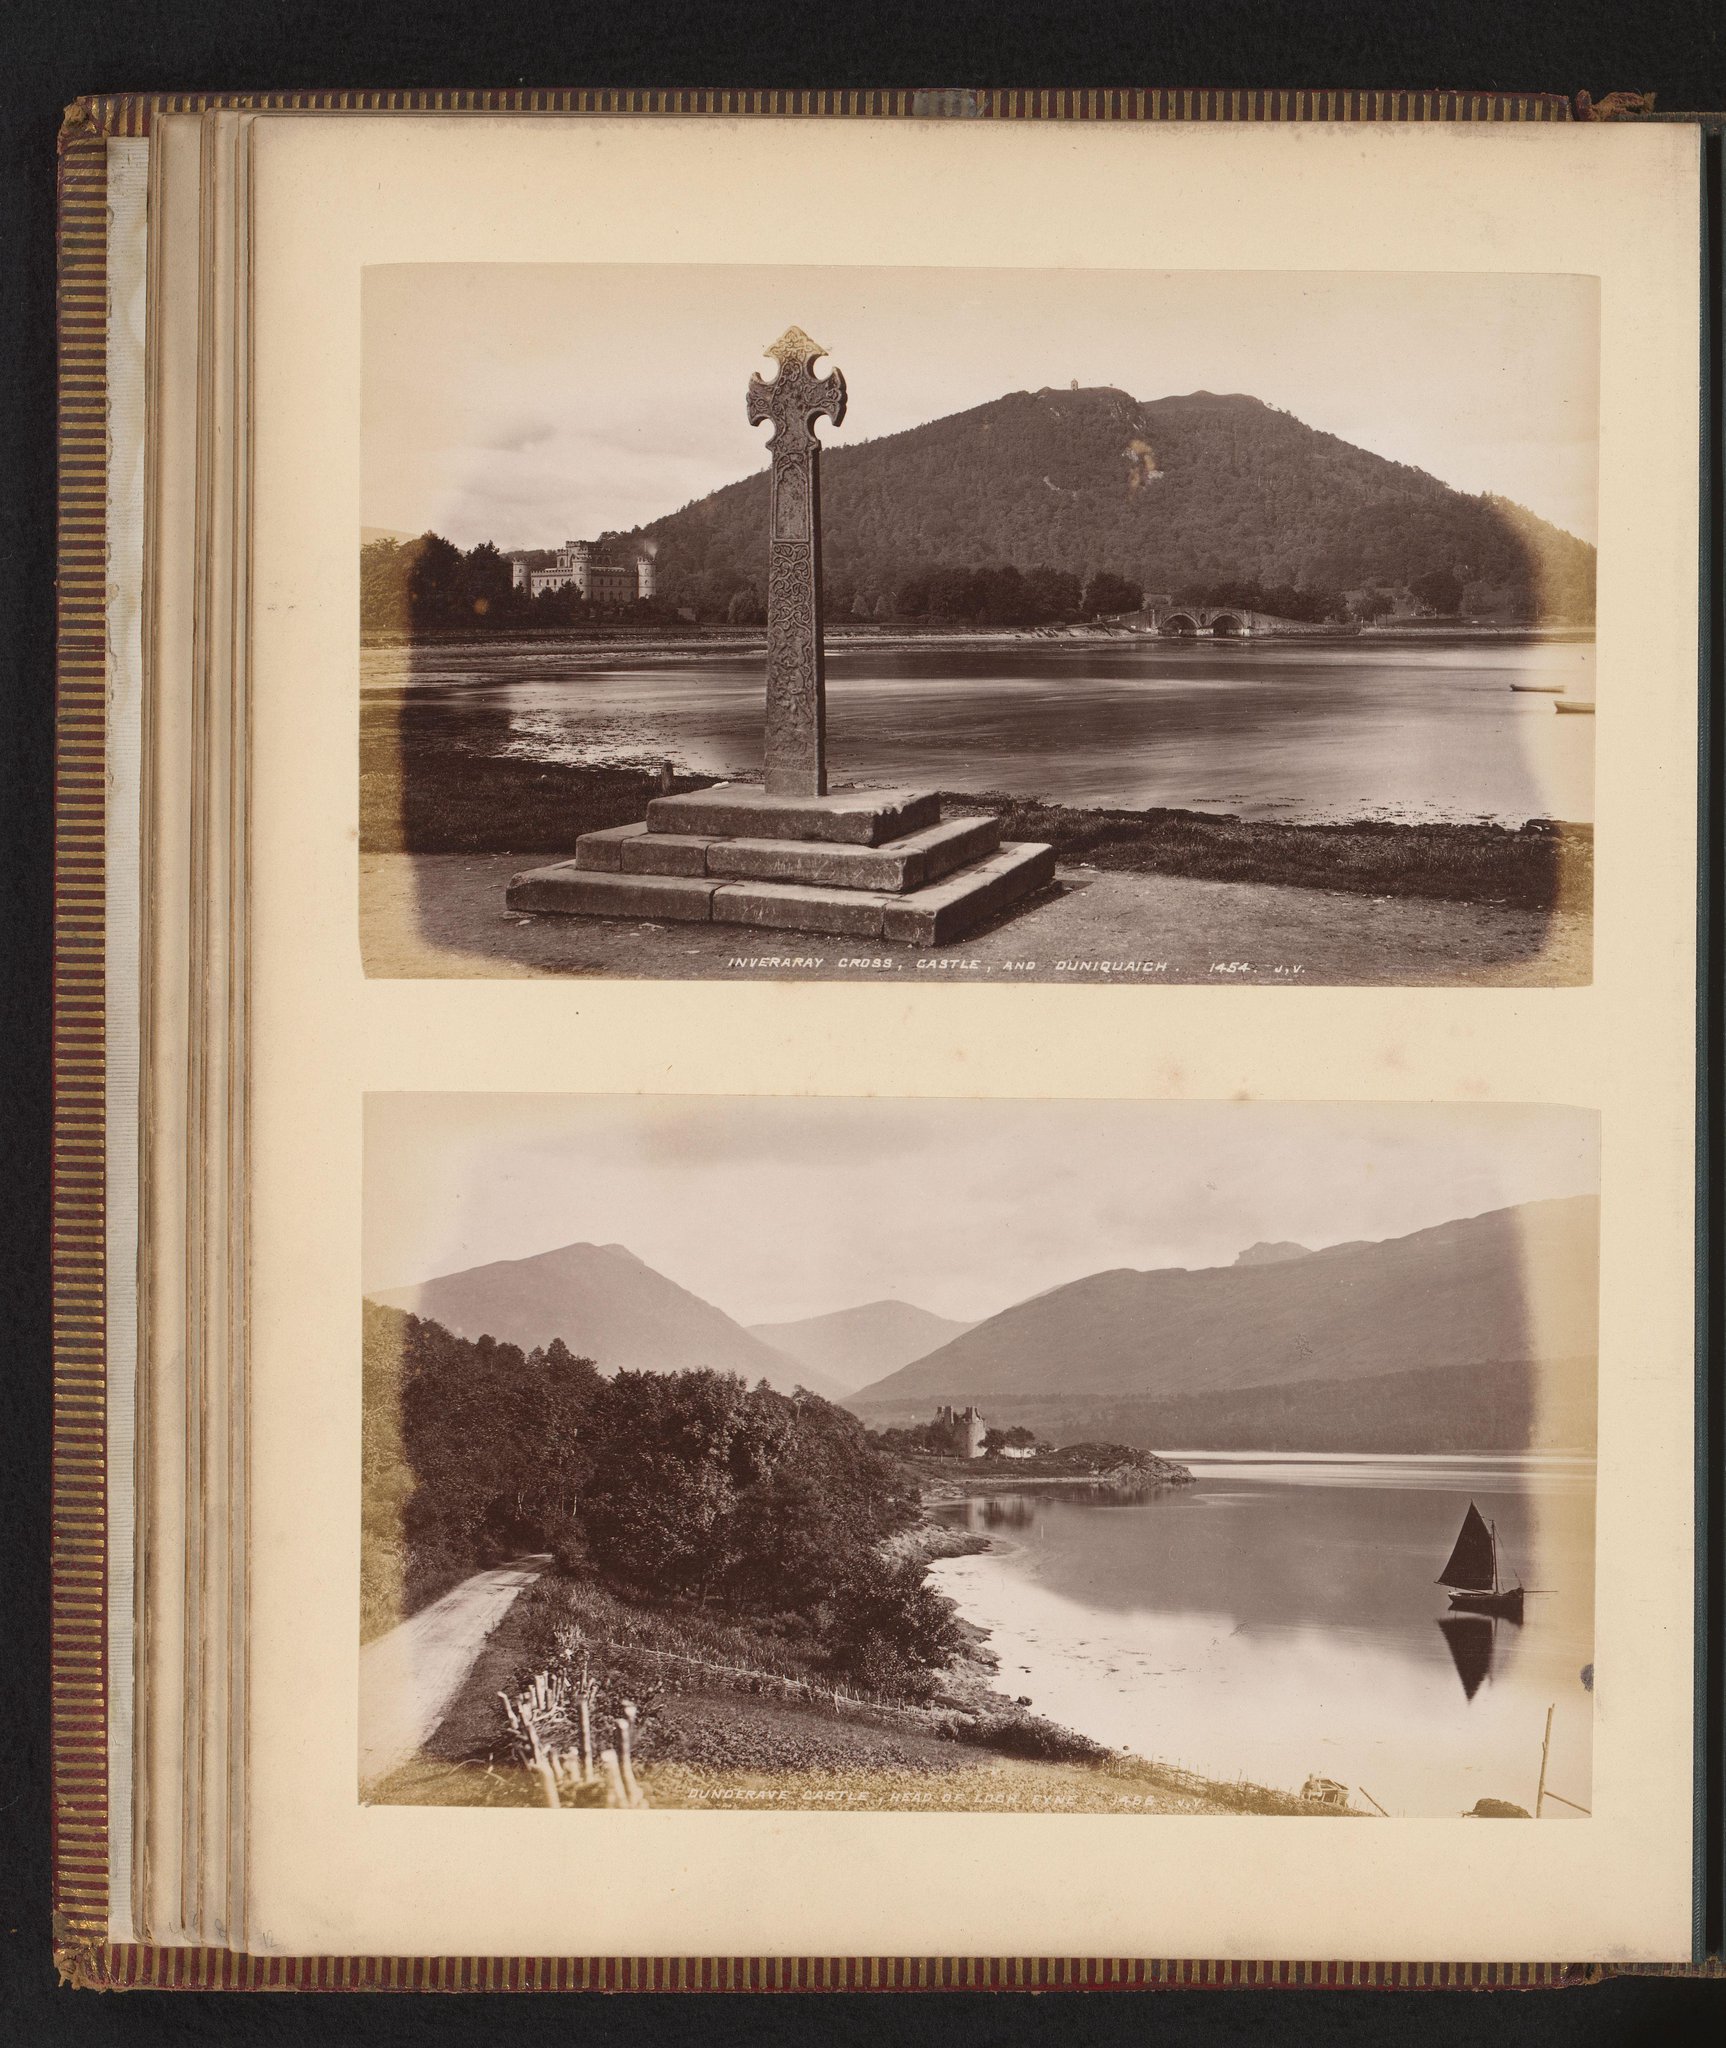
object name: photograph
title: Inveraray Cross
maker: Anonymous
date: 1875-1885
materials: photographic support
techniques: albumen print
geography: inveraray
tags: sailing-ship, sailing-boat, castle, places and objects of worship ~ celtic religion, landscapes with waters, waterscapes, seascapes (in the temperate zone)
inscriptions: number: ‘1466, J.V.’, number: ‘1454, J.V.’